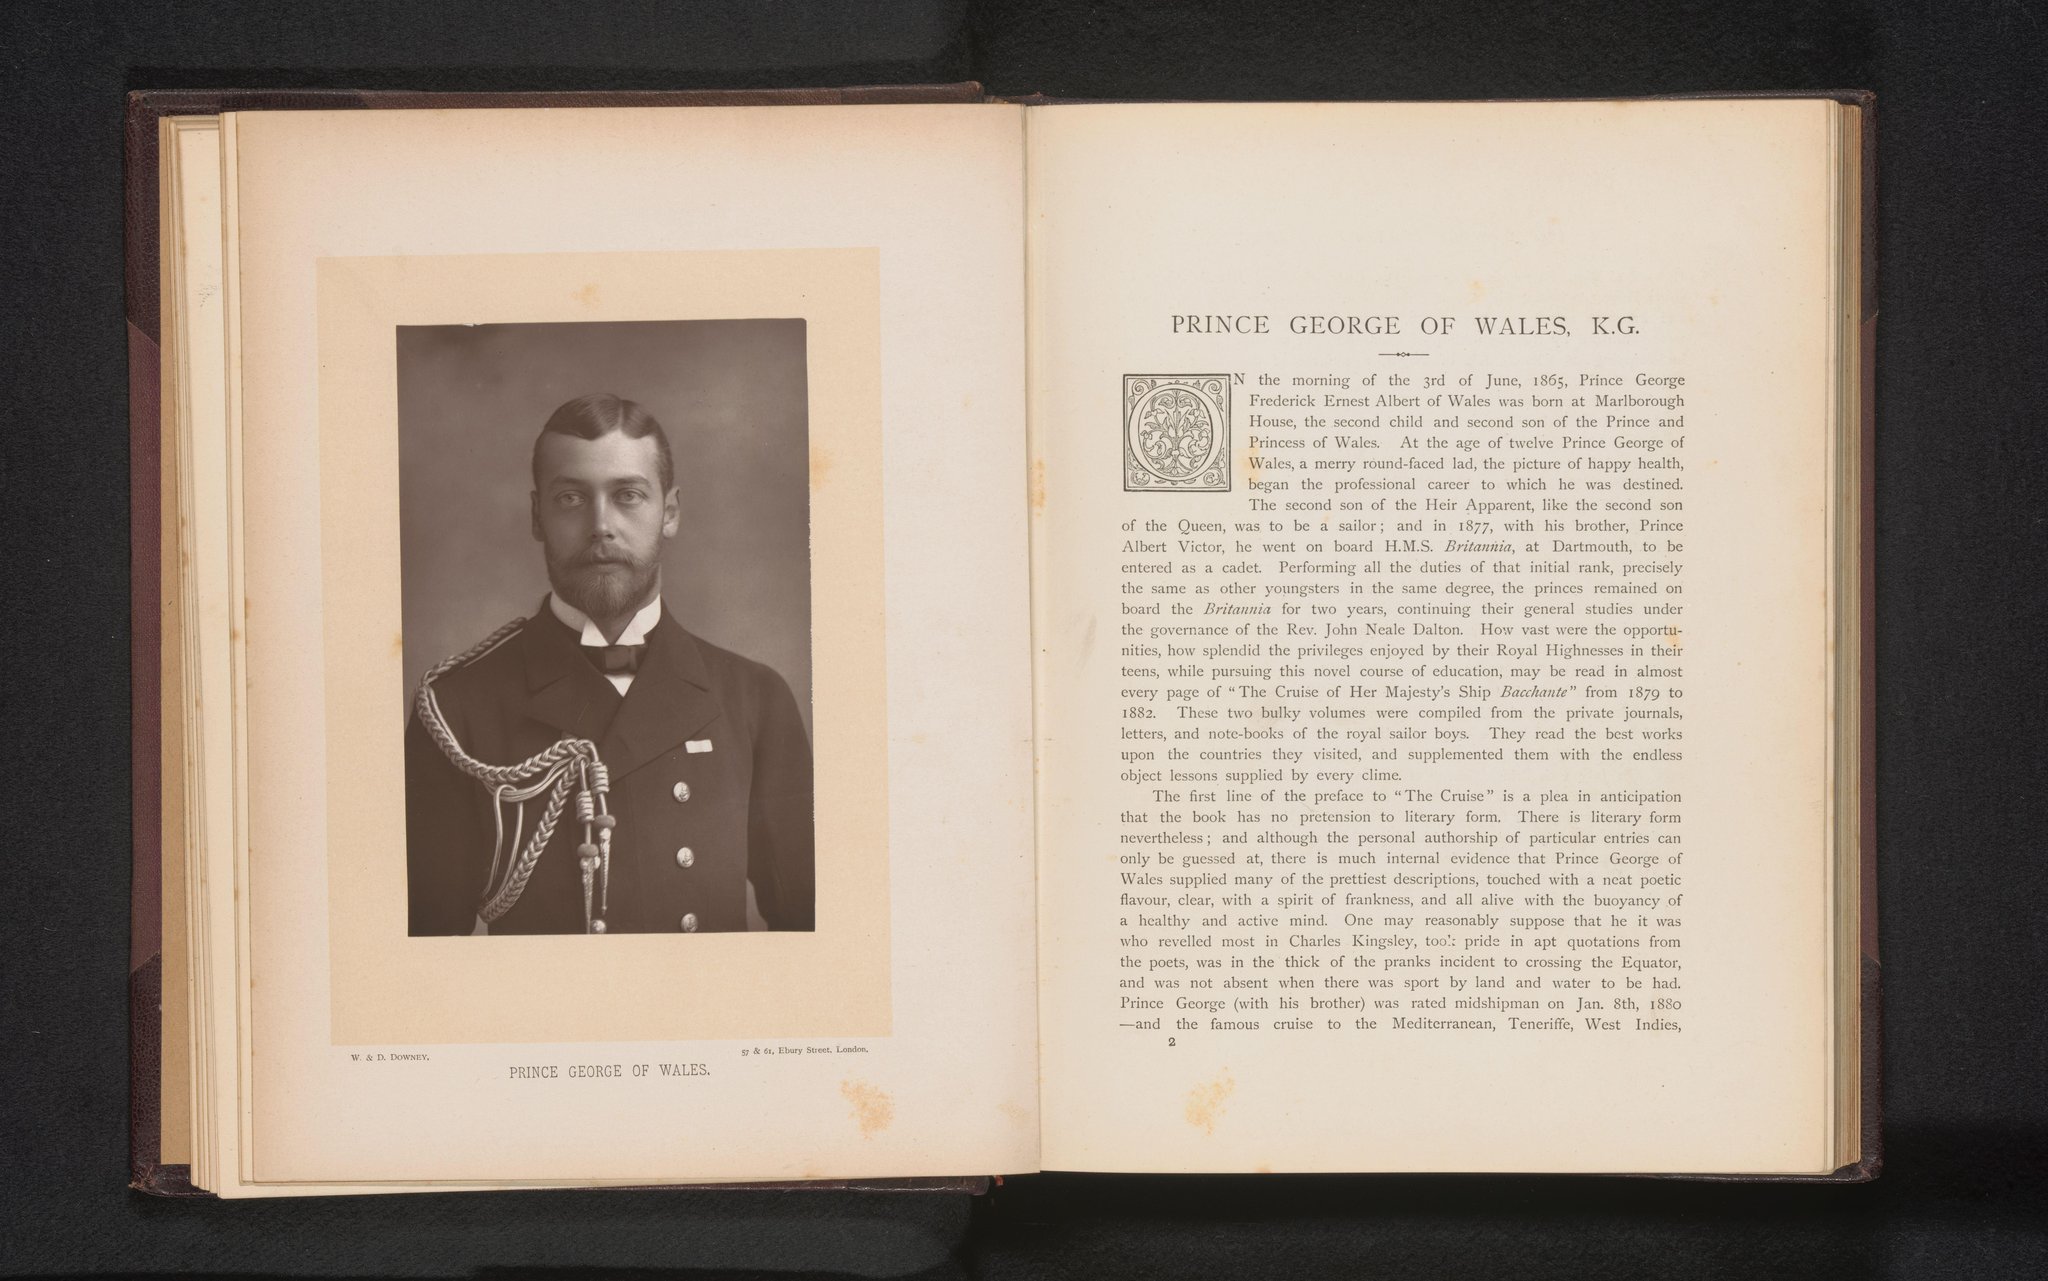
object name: photomechanical print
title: Portret van prins George V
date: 1885-1890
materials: paper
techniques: woodburytype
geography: london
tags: london, historical persons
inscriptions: address: ‘57 & 61, Ebury Street, London.’